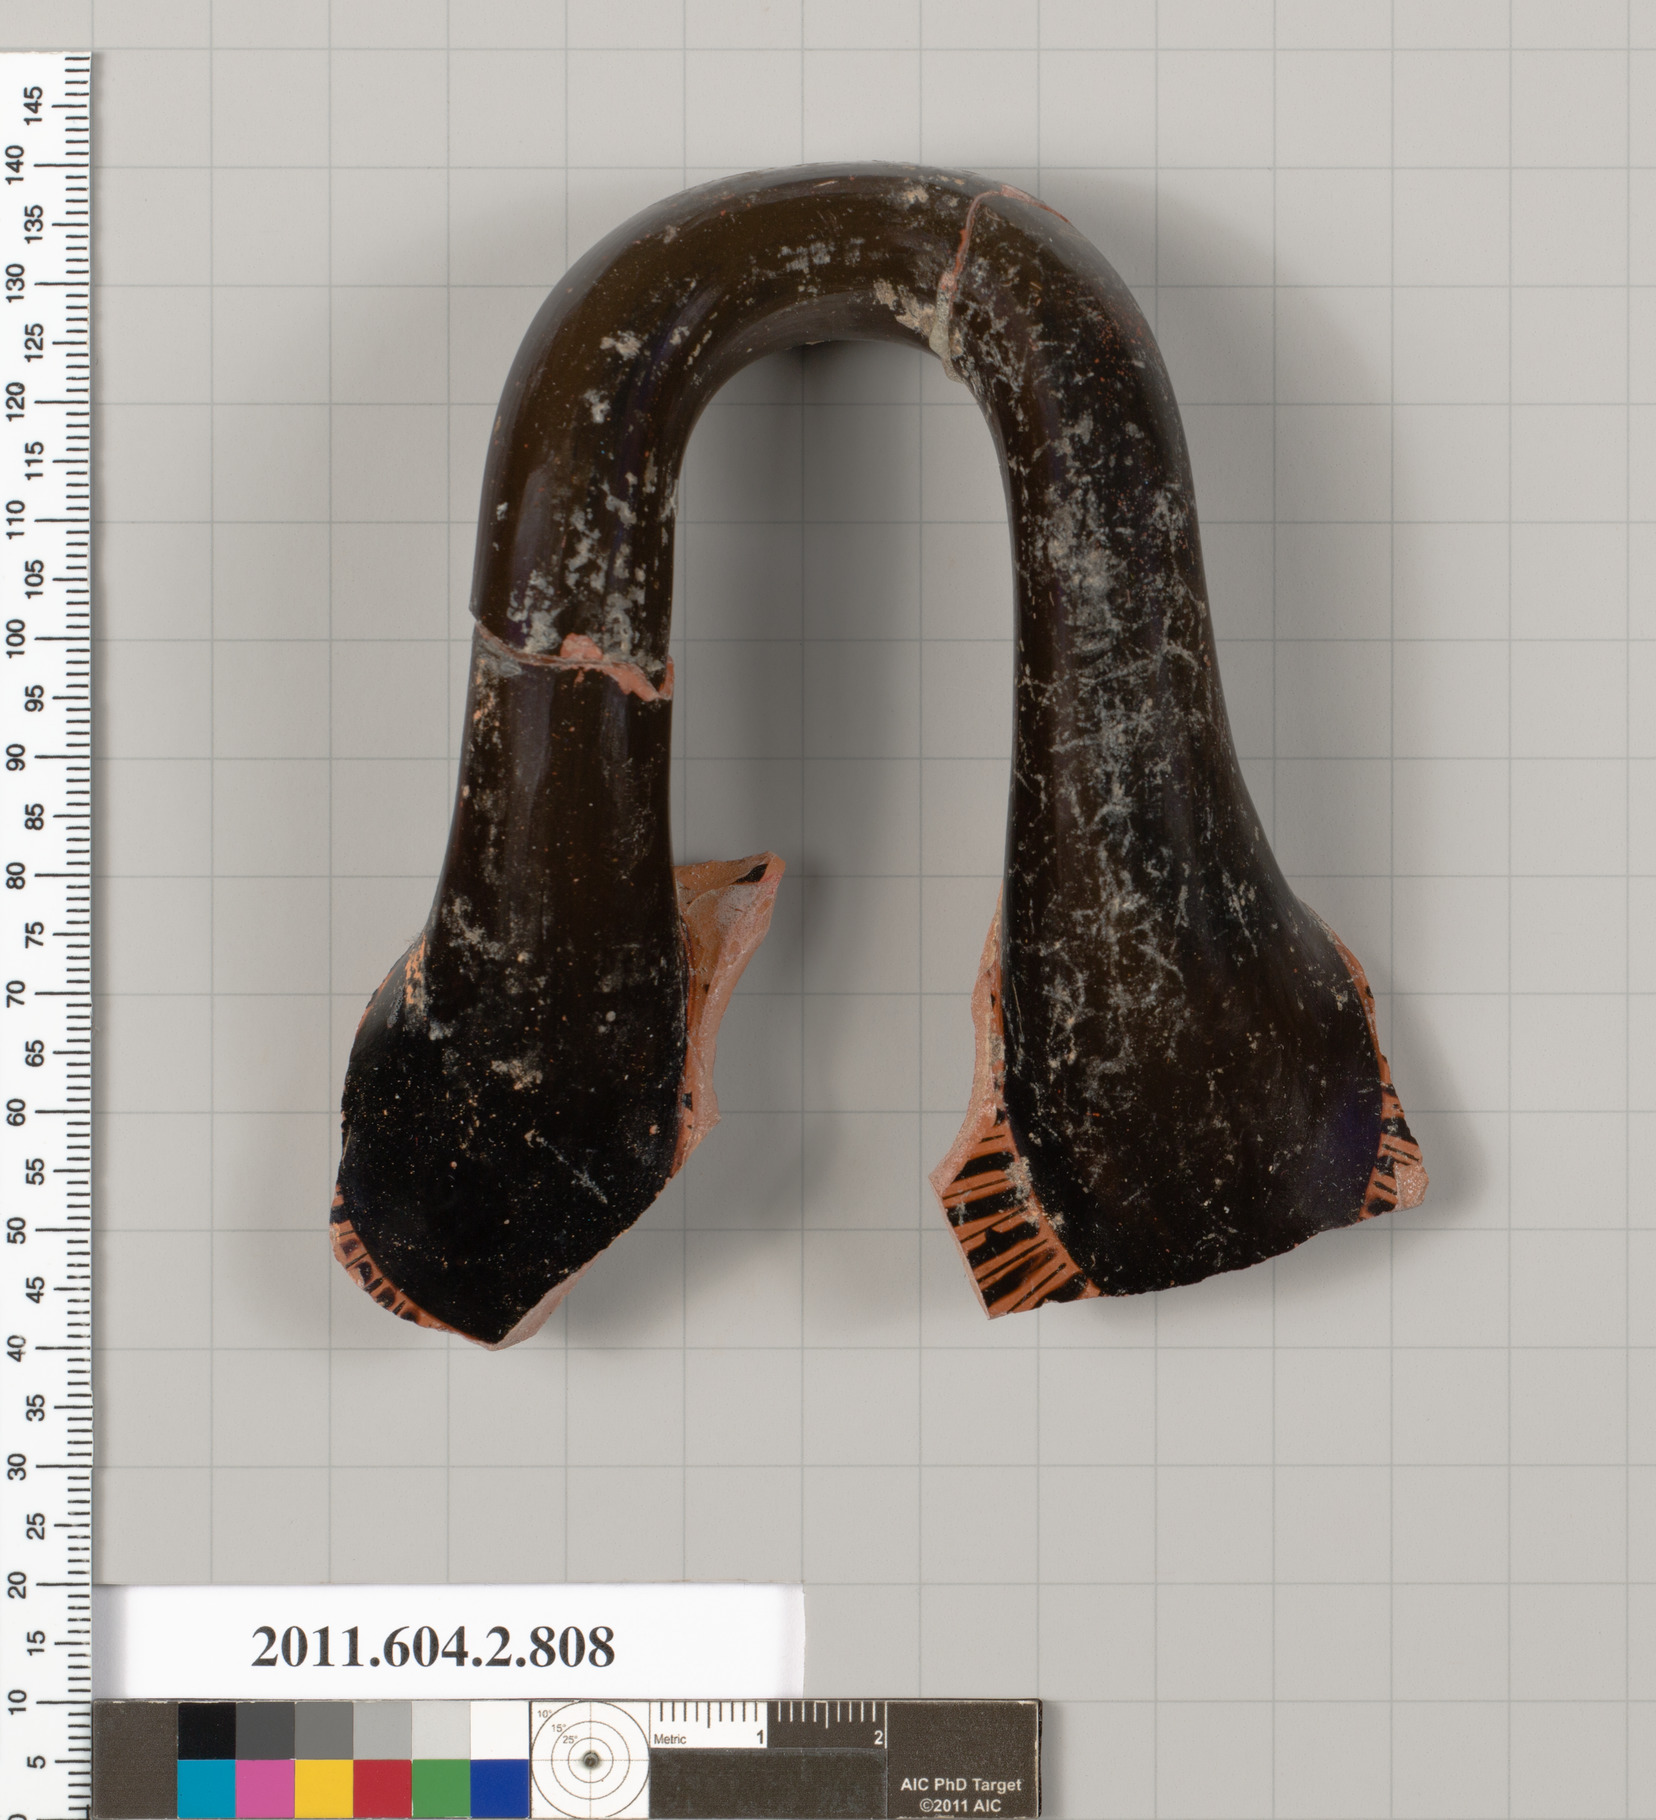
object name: calyx krater fragment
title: Terracotta fragment of a calyx-krater (bowl for mixing wine and water)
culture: greek, attic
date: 475-451 BCE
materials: terracotta